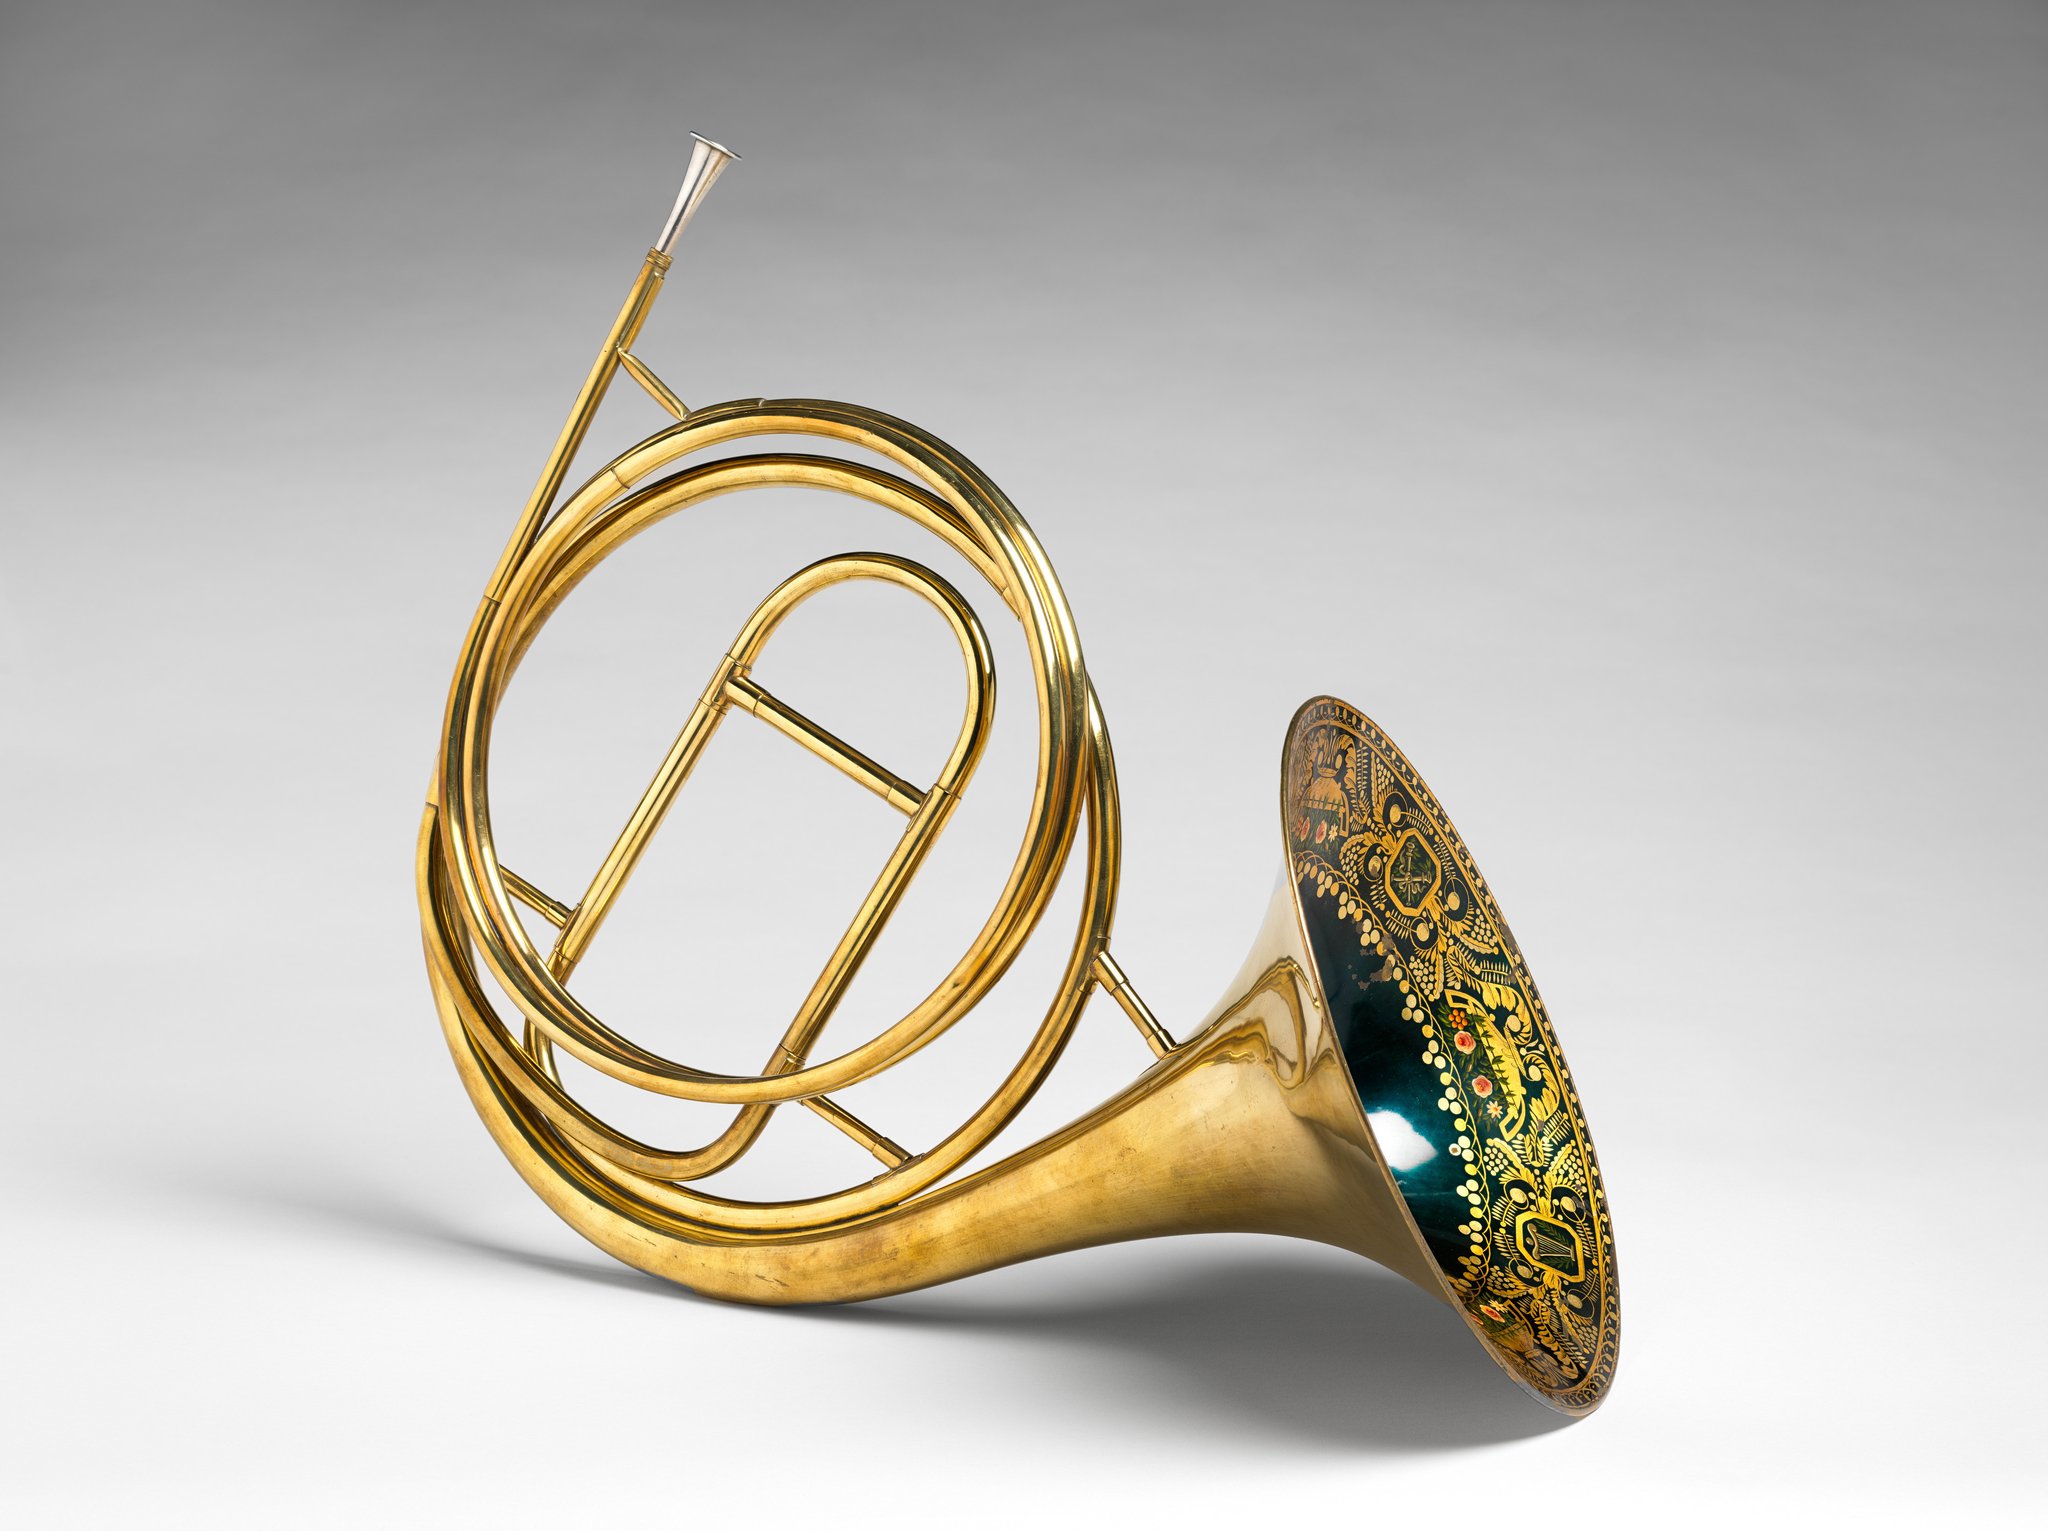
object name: cor d orchestre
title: Cor d’orchestre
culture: french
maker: courtois neveu aine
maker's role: maker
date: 1830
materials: brass, leather, horn, iron, metal, paint, paper, wood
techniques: polychrome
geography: united states